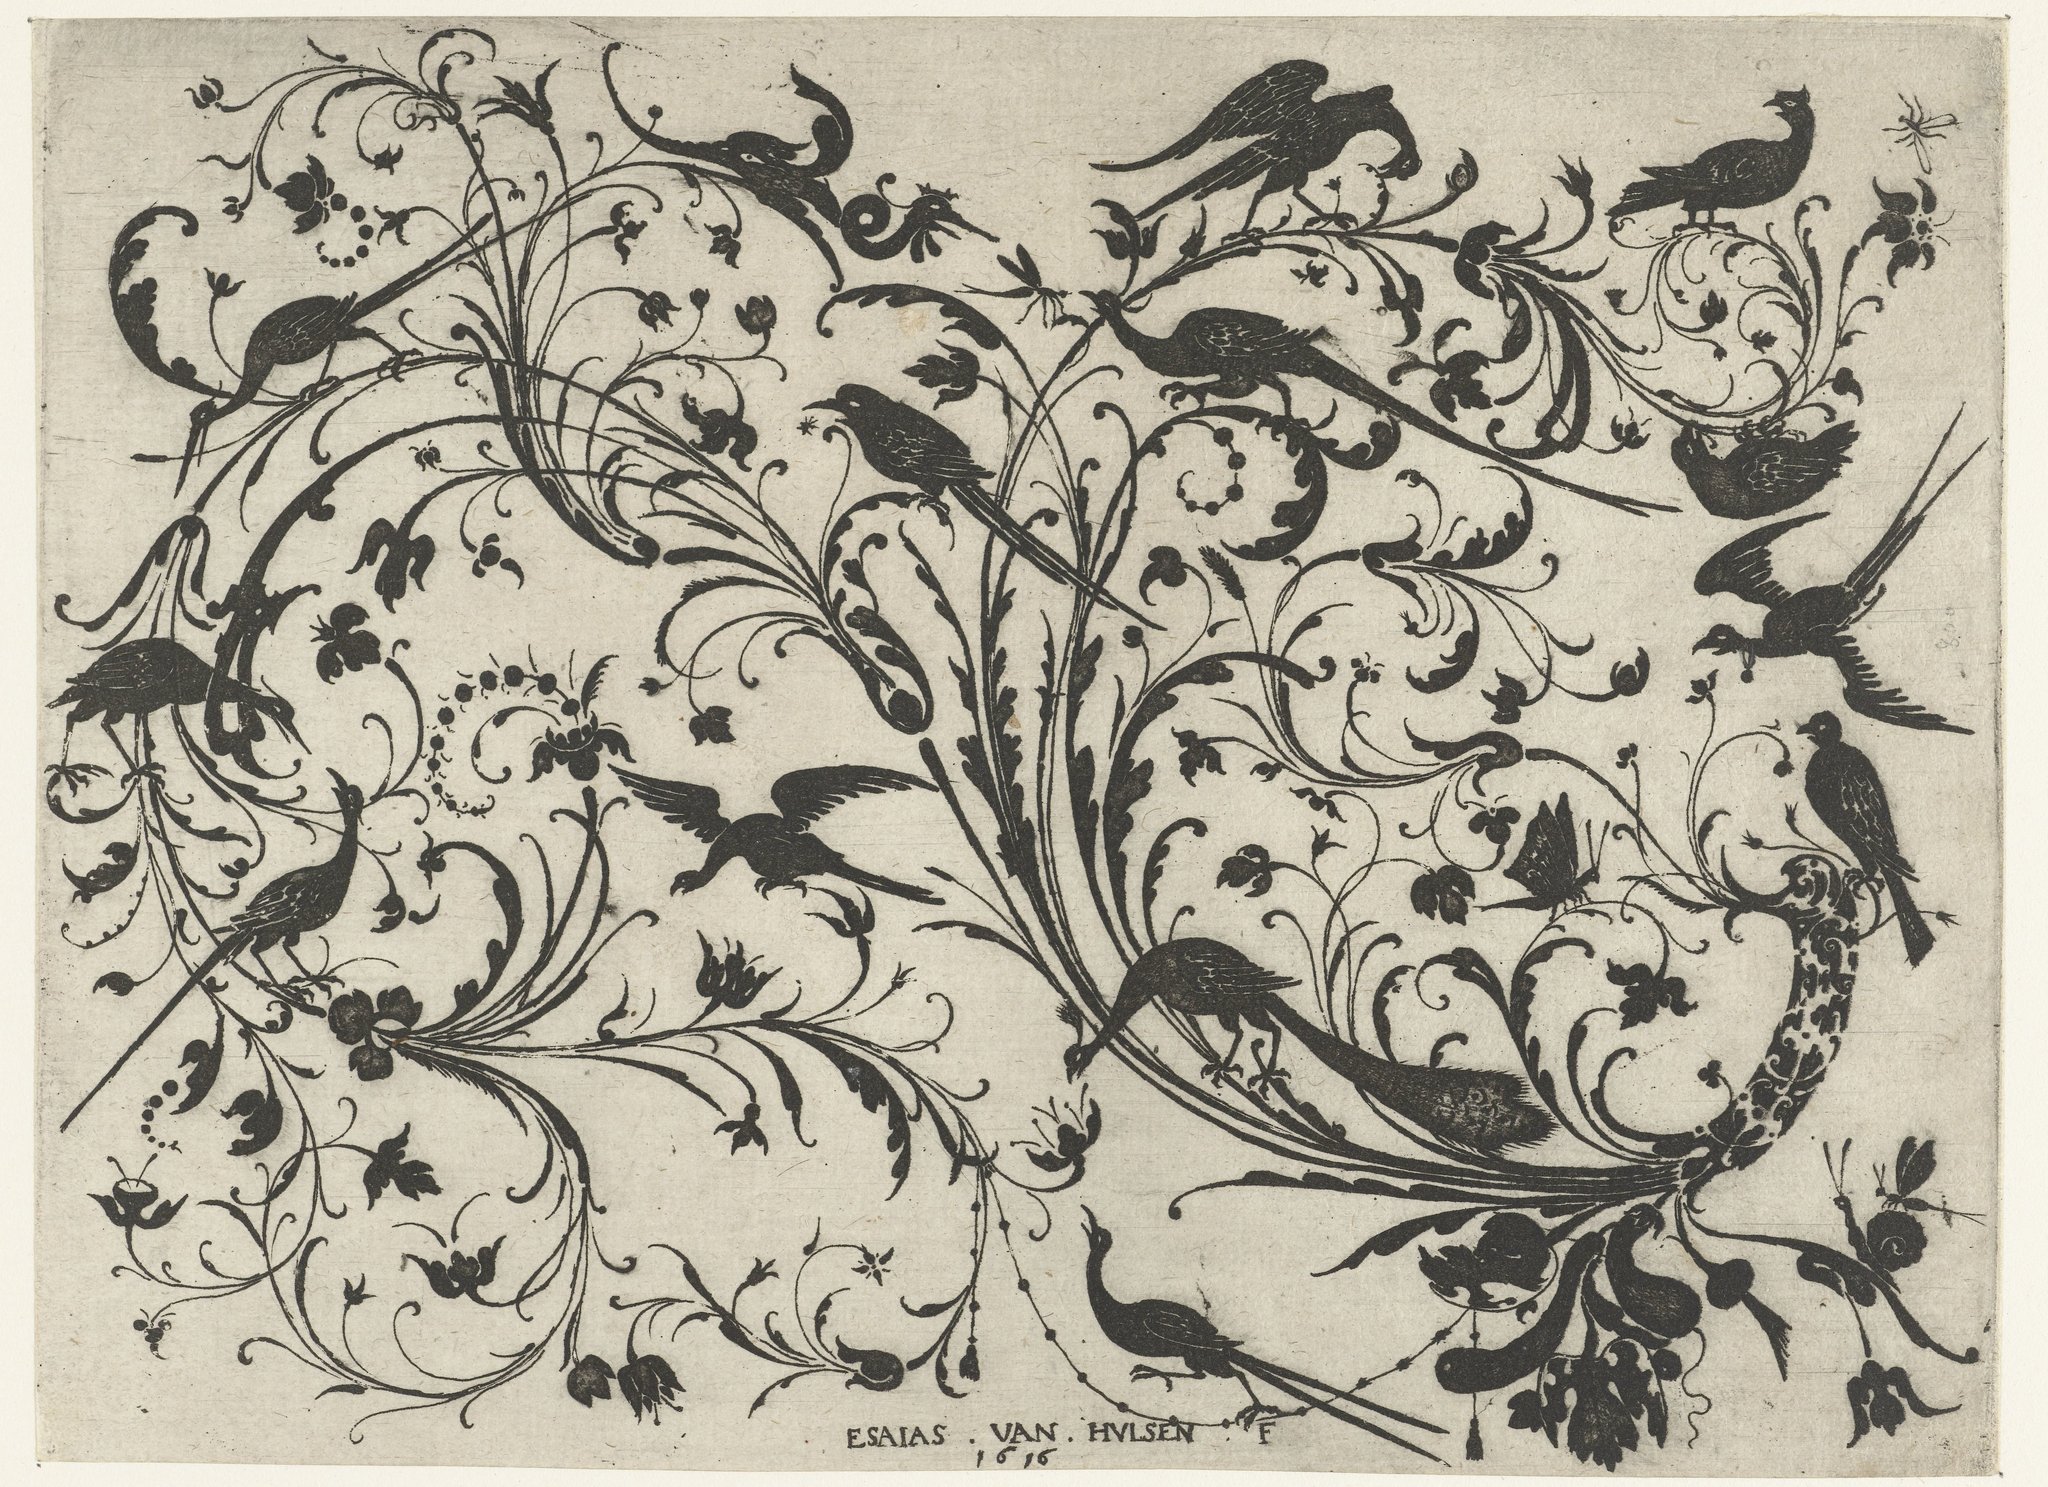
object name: ornament print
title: Bladranken met bloemen en vogels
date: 1616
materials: paper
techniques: etching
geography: stuttgart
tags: flowers, birds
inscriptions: date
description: De bladranken waaieren uit vanuit de hoek rechtsonder. Zwartornament uit serie van 6 bladen met ornamenten voor ambachtslieden in edelmetaal en emaille.